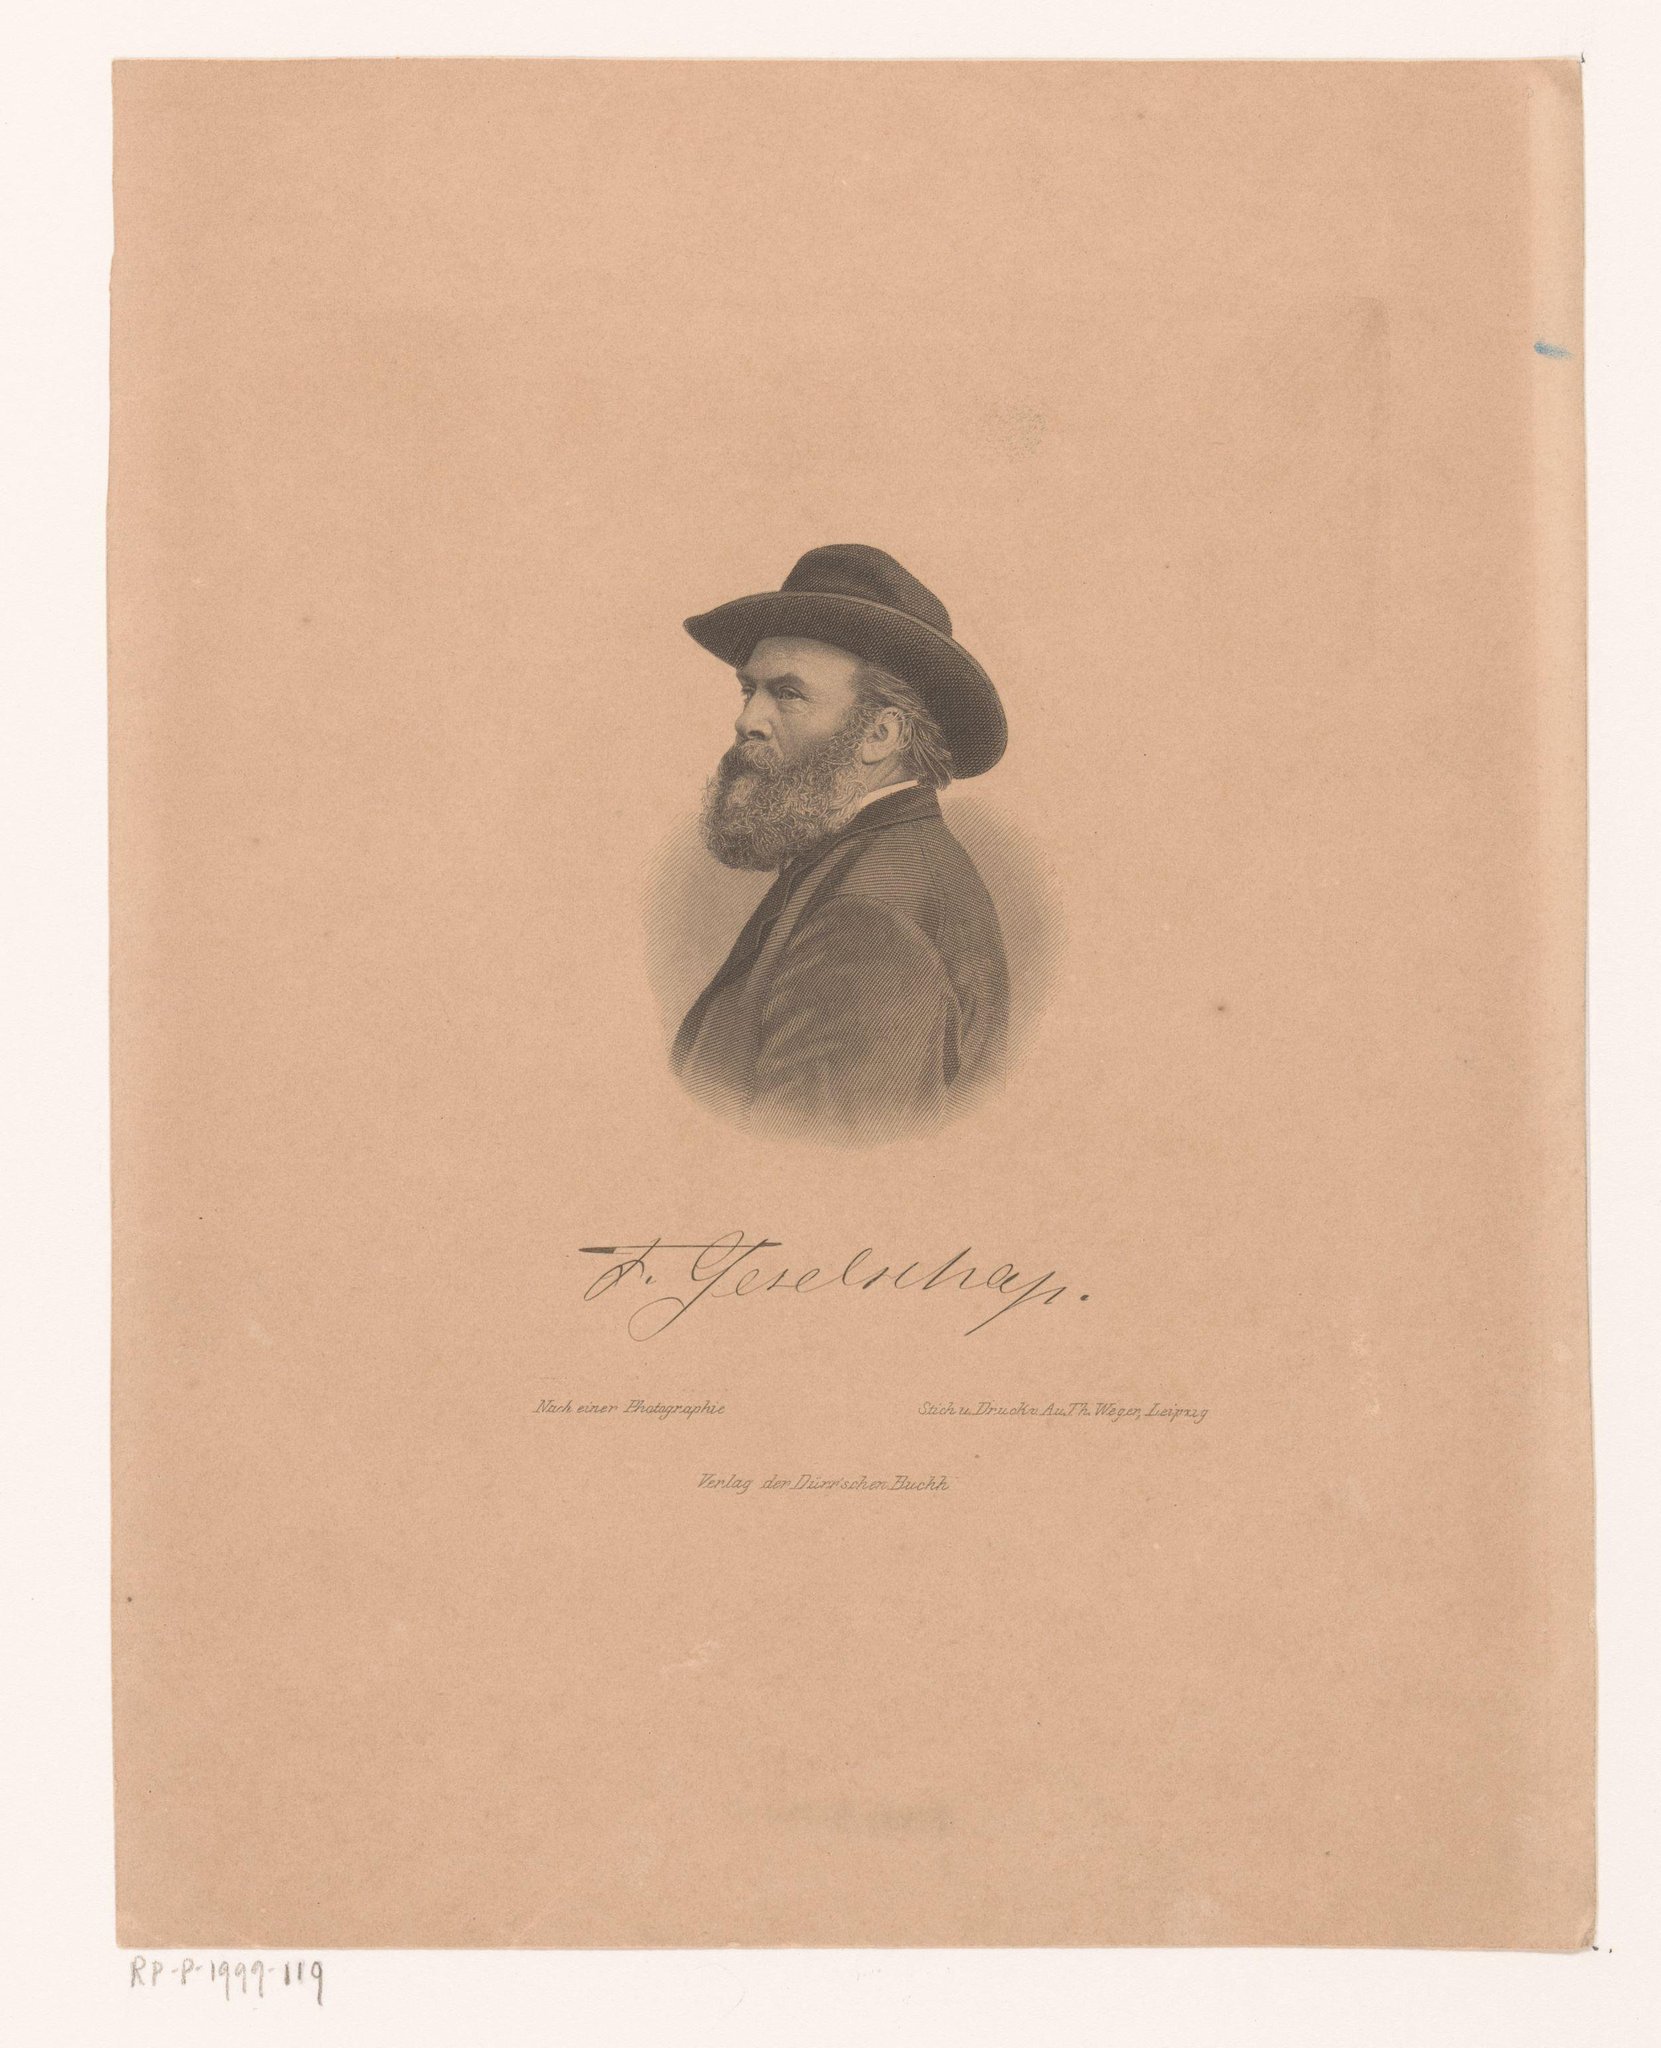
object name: print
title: Portret van Friedrich Geselschap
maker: august weger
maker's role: print maker, printer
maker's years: 1823-1892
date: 1865-1892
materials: paper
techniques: engraving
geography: leipzig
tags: painter, historical persons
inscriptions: collector's mark: Lugt 2760, collector's mark: Lugt 2228, collector's mark: ‘Franz Radestock’